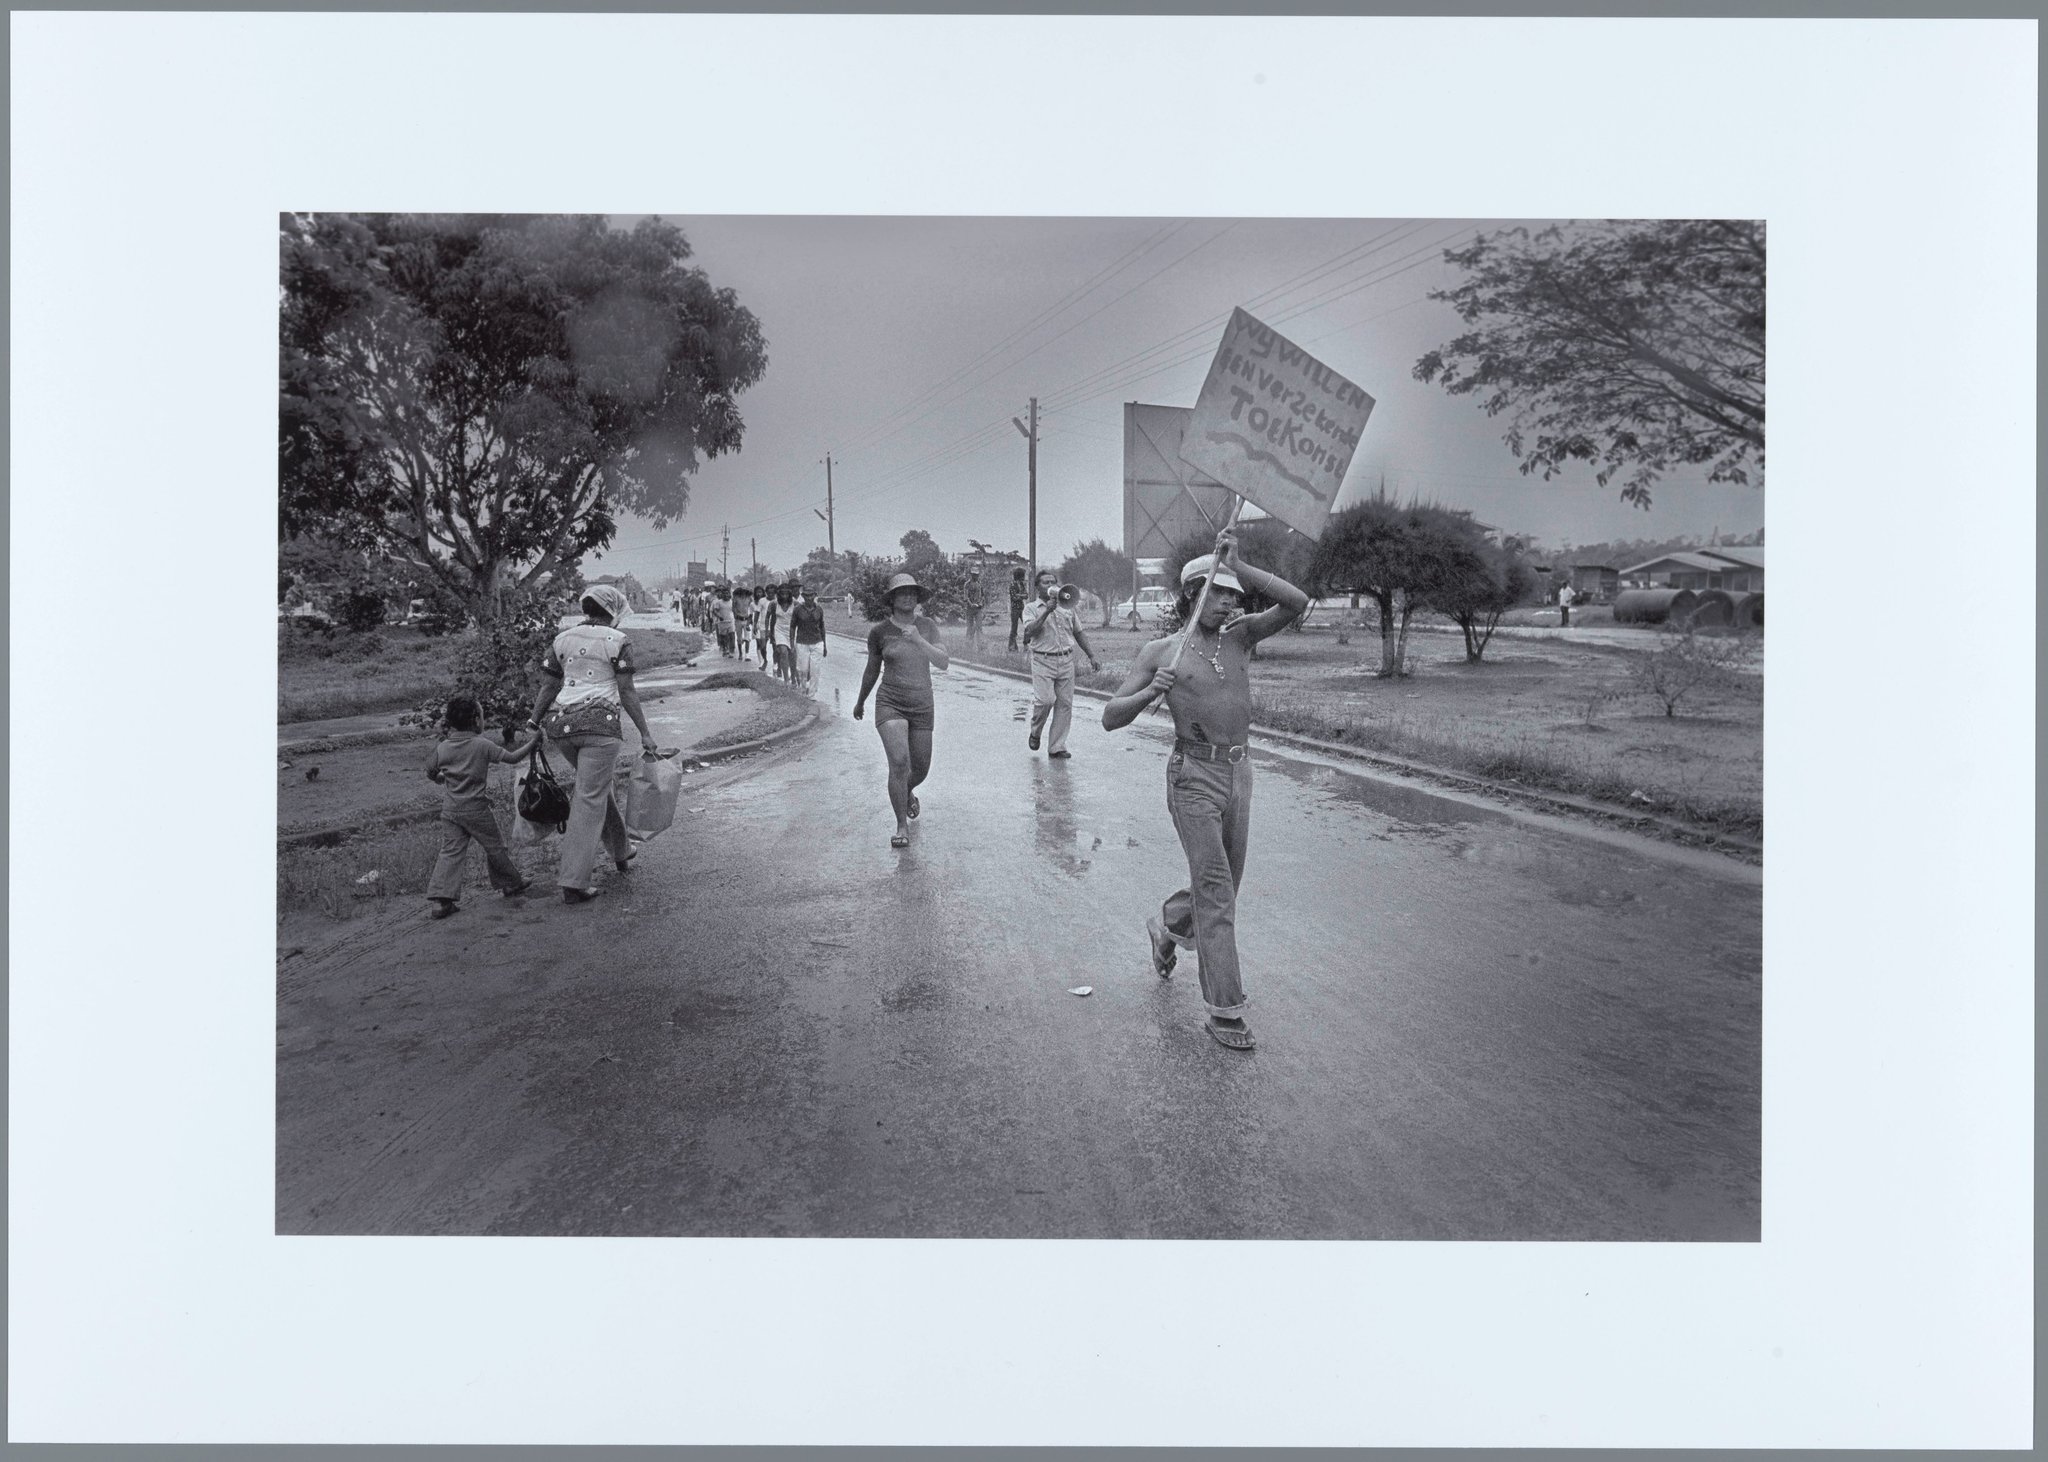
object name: photograph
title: Mars, 29 december 1976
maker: cary markerink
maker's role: fotograaf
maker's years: 1951-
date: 1976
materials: paper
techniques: gelatin silver print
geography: suriname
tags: political demonstration, suriname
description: Onderdeel van een serie foto's die een protestmars vastleggen van een groep Caraïben en Arowakken die eind december 1976 in vier dagen van hun woonplaatsen aan de kust via Albina naar Paramaribo liepen. Zij vroegen met hun actie aandacht voor hun grondrechten en de algemene positie van de nazaten van de oorspronkelijke bewoners van Suriname. In Paramaribo werden ze in het presidentieel paleis ontvangen door president J. Ferrier. De fotograaf was bevriend met een van de initiatiefnemers en liep mee met de mars.